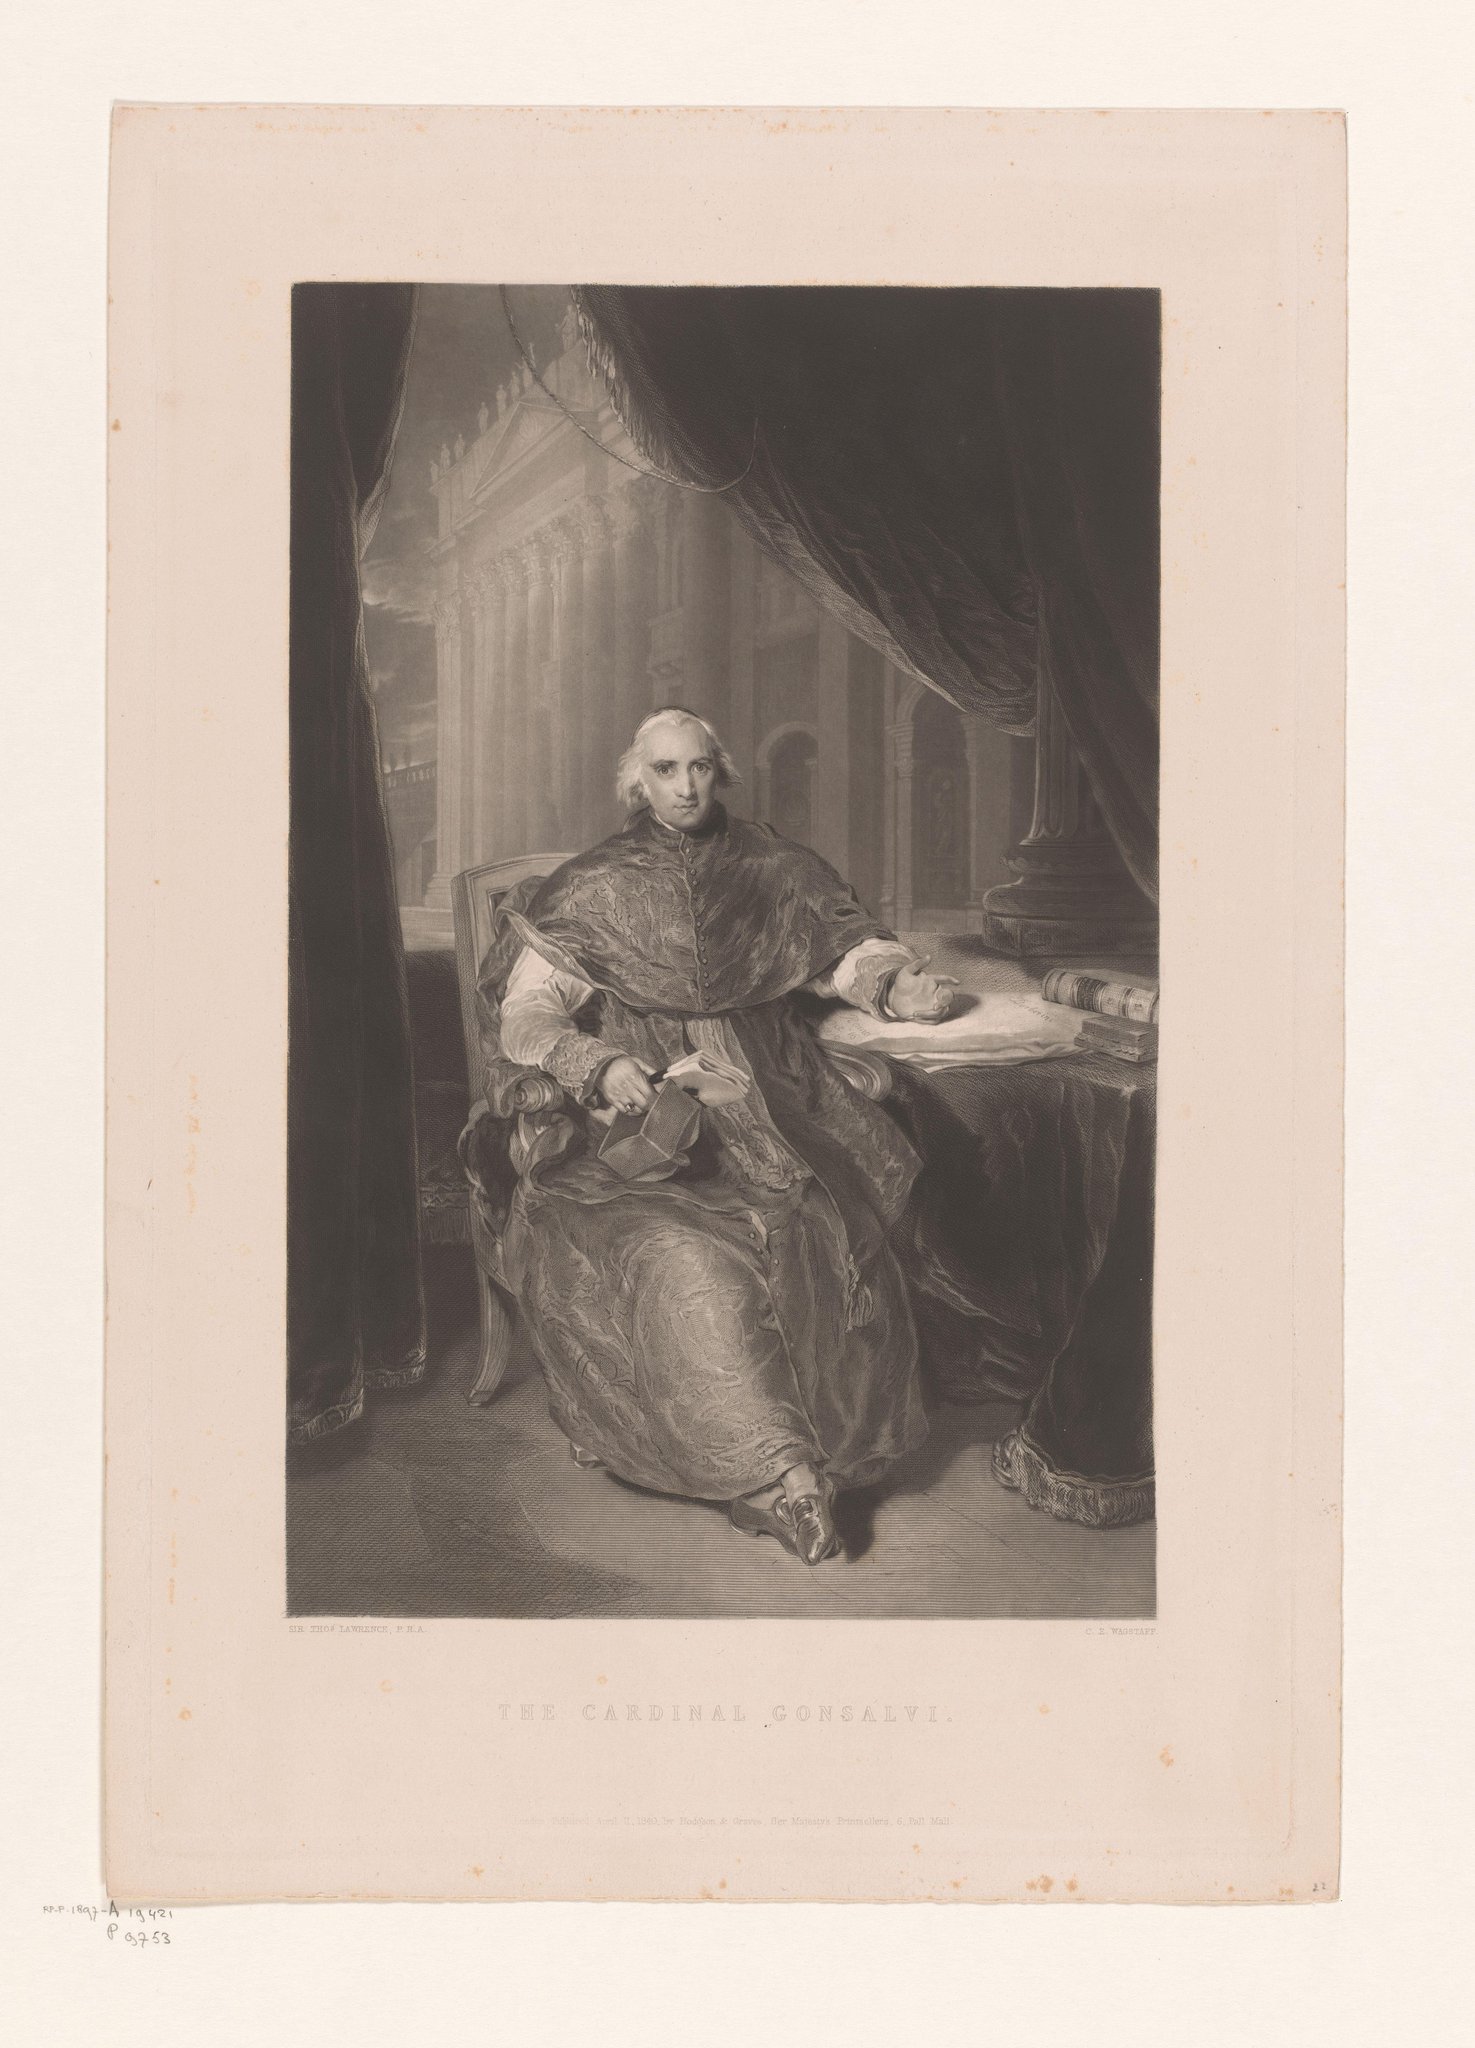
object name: print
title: Portret van Ercole Consalvi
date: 1804-1840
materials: paper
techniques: etching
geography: london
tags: rome, ercole consalvi, cardinal, historical persons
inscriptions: collector's mark: Lugt 2228